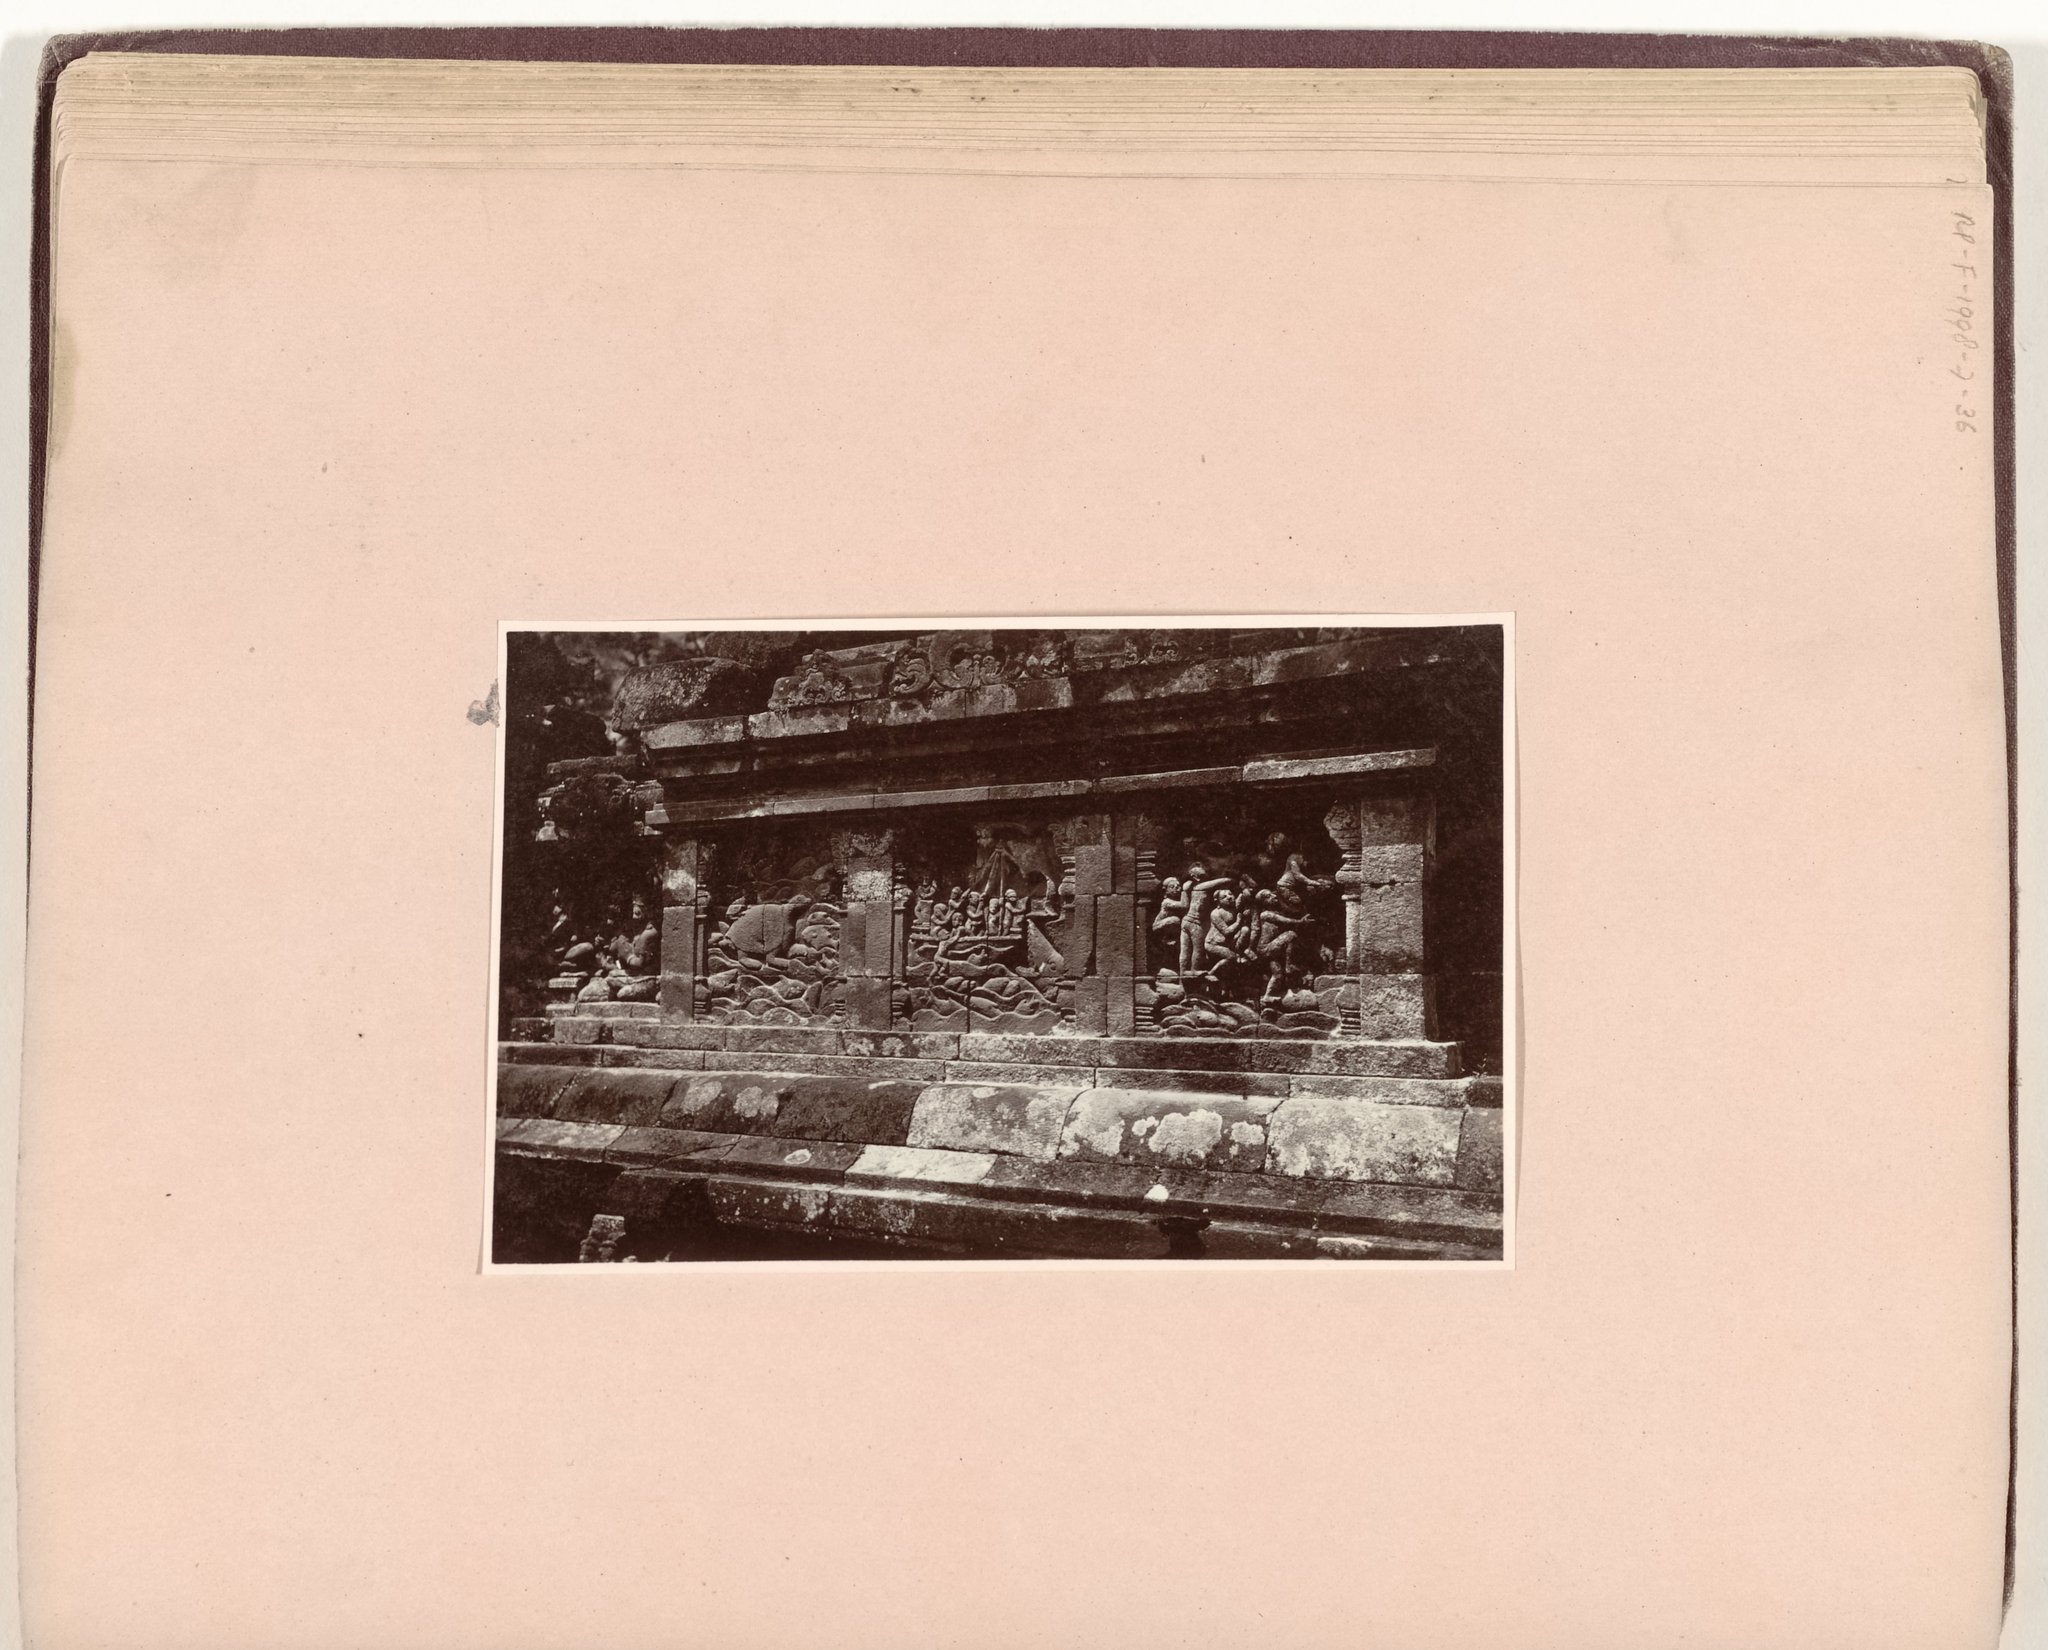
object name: album leaf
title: Reliëf van de Borobudur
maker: c. dietrich (fotograaf)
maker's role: fotograaf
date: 1875-1890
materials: cardboard, paper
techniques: albumen print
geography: java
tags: sculpture (+ relief ~ sculpture)